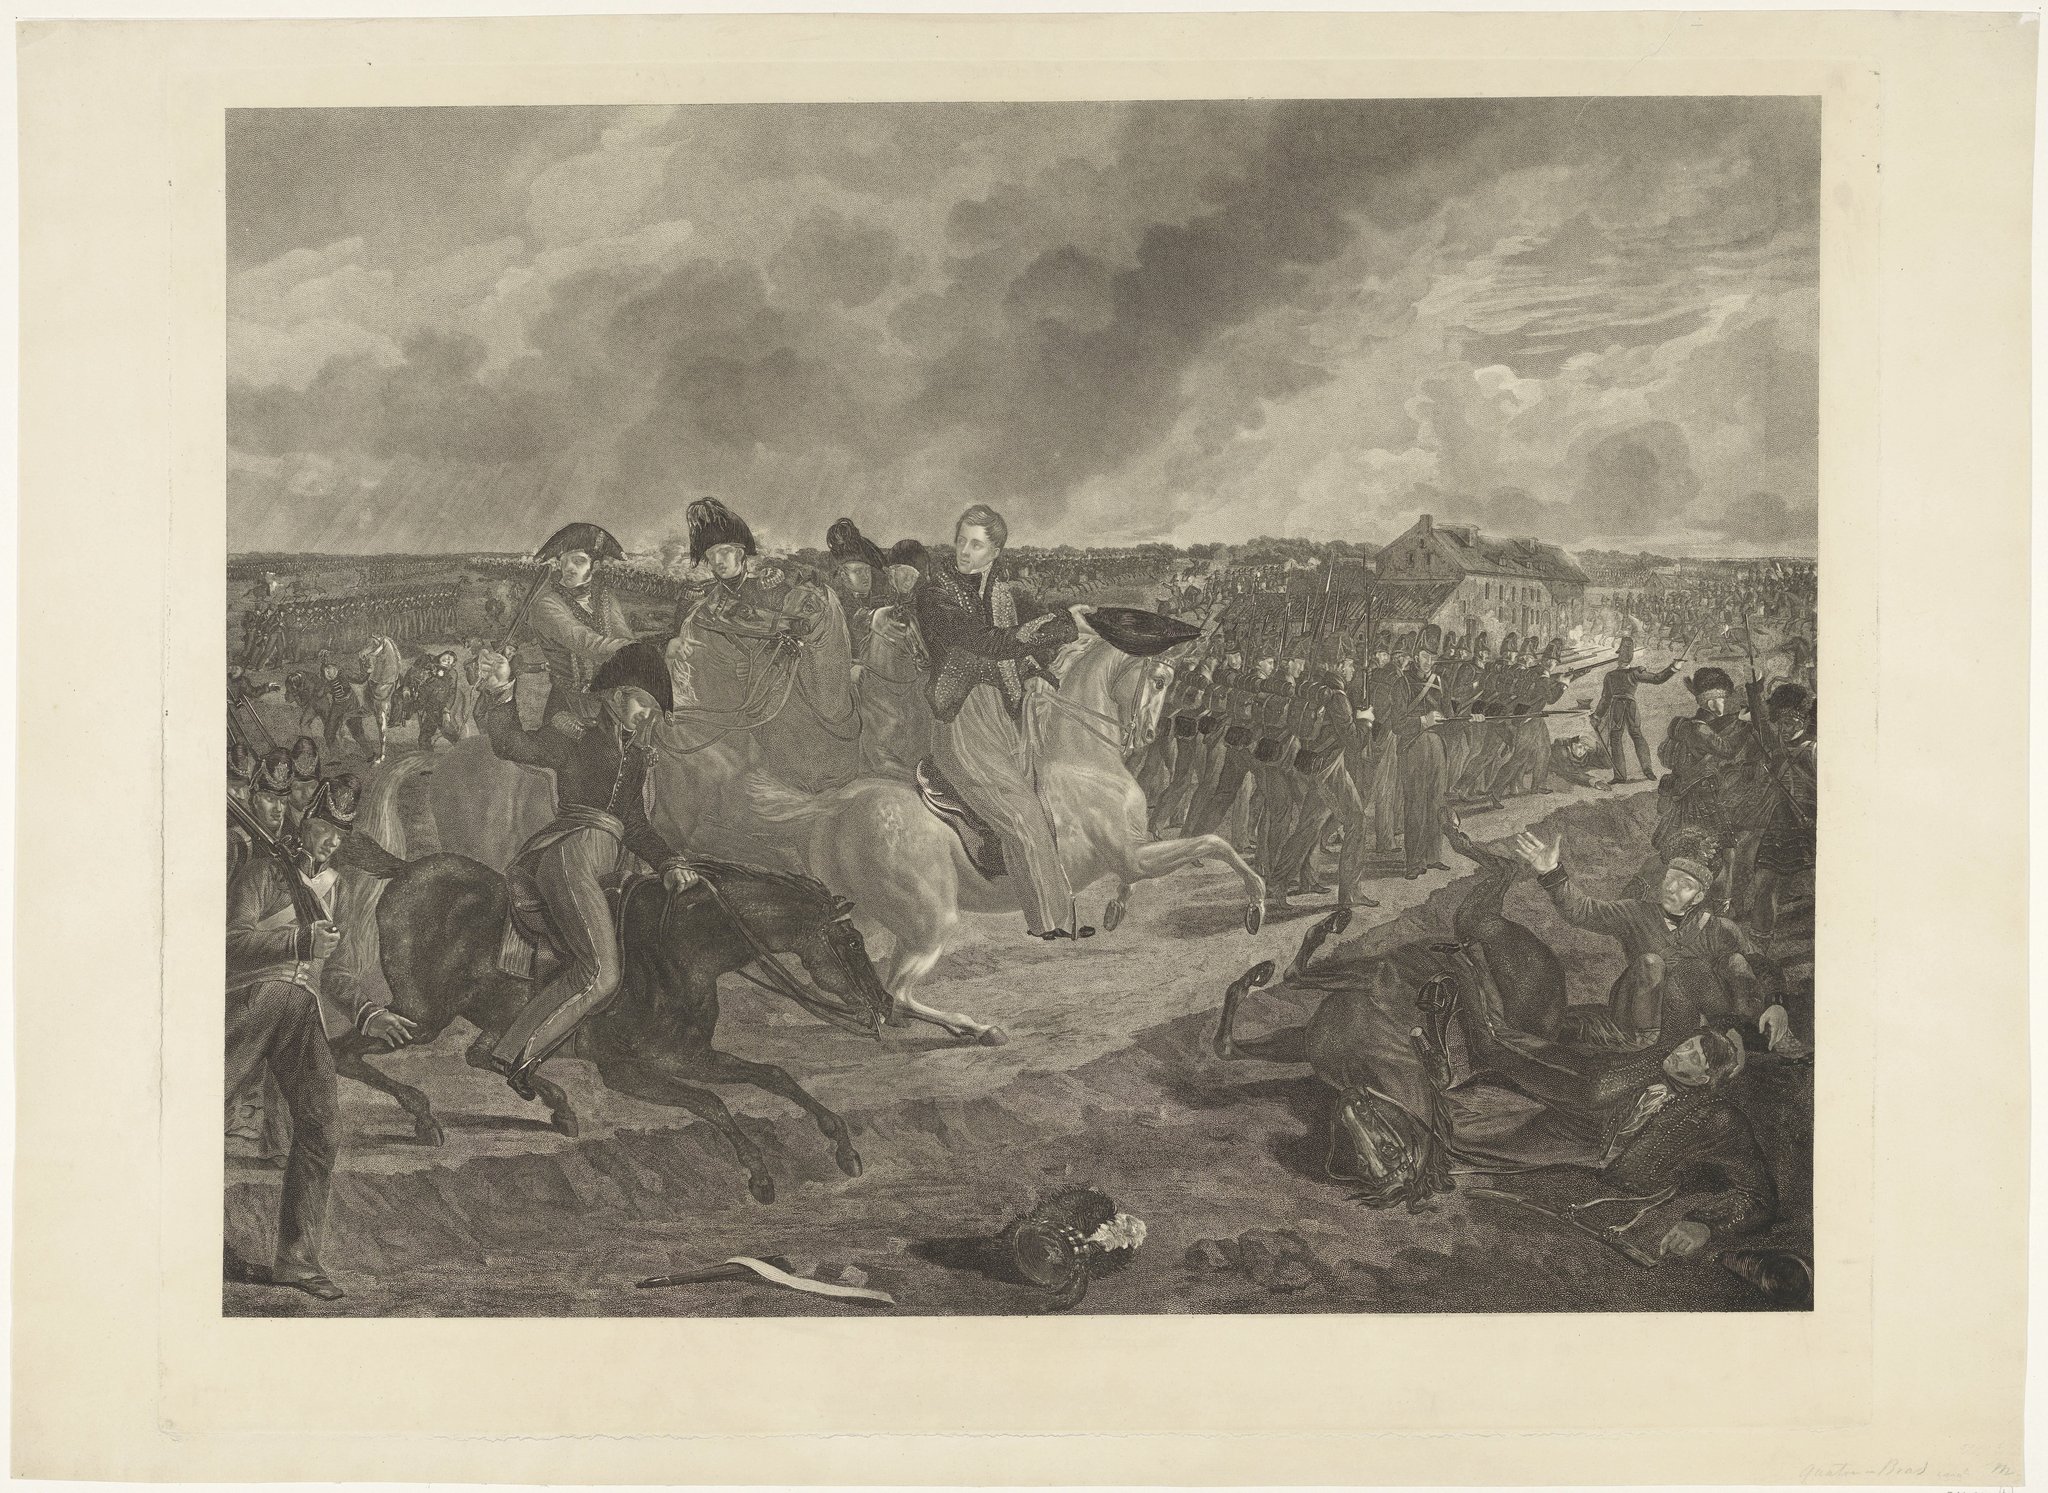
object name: print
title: Prins van Oranje in de slag bij Quatre-Bras, 1815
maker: willem van senus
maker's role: painter, print maker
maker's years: 1773-1851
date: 1817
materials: paper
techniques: etching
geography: netherlands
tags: the hague, william ii of the netherlands, battle (+ land forces)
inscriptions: collector's mark: Lugt 2228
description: De prins van Oranje leidt te paard de Nederlandse troepen tijdens de slag bij Quatre-Bras, 16 juni 1815. Centraal de prins te paard omgeven door zijn staf. Rechts vuurt de Nederlandse infanterie op de aanstormde Franse kurassiers. Op de voorgrond gewonde miliatiren op de grond. Links op de achtergrond wordt de dodelijk gewonde Frederik Willem, hertog van Brunswijk-Lüneburg-Oels van het slagveld gedragen. Zie ook de pendant.